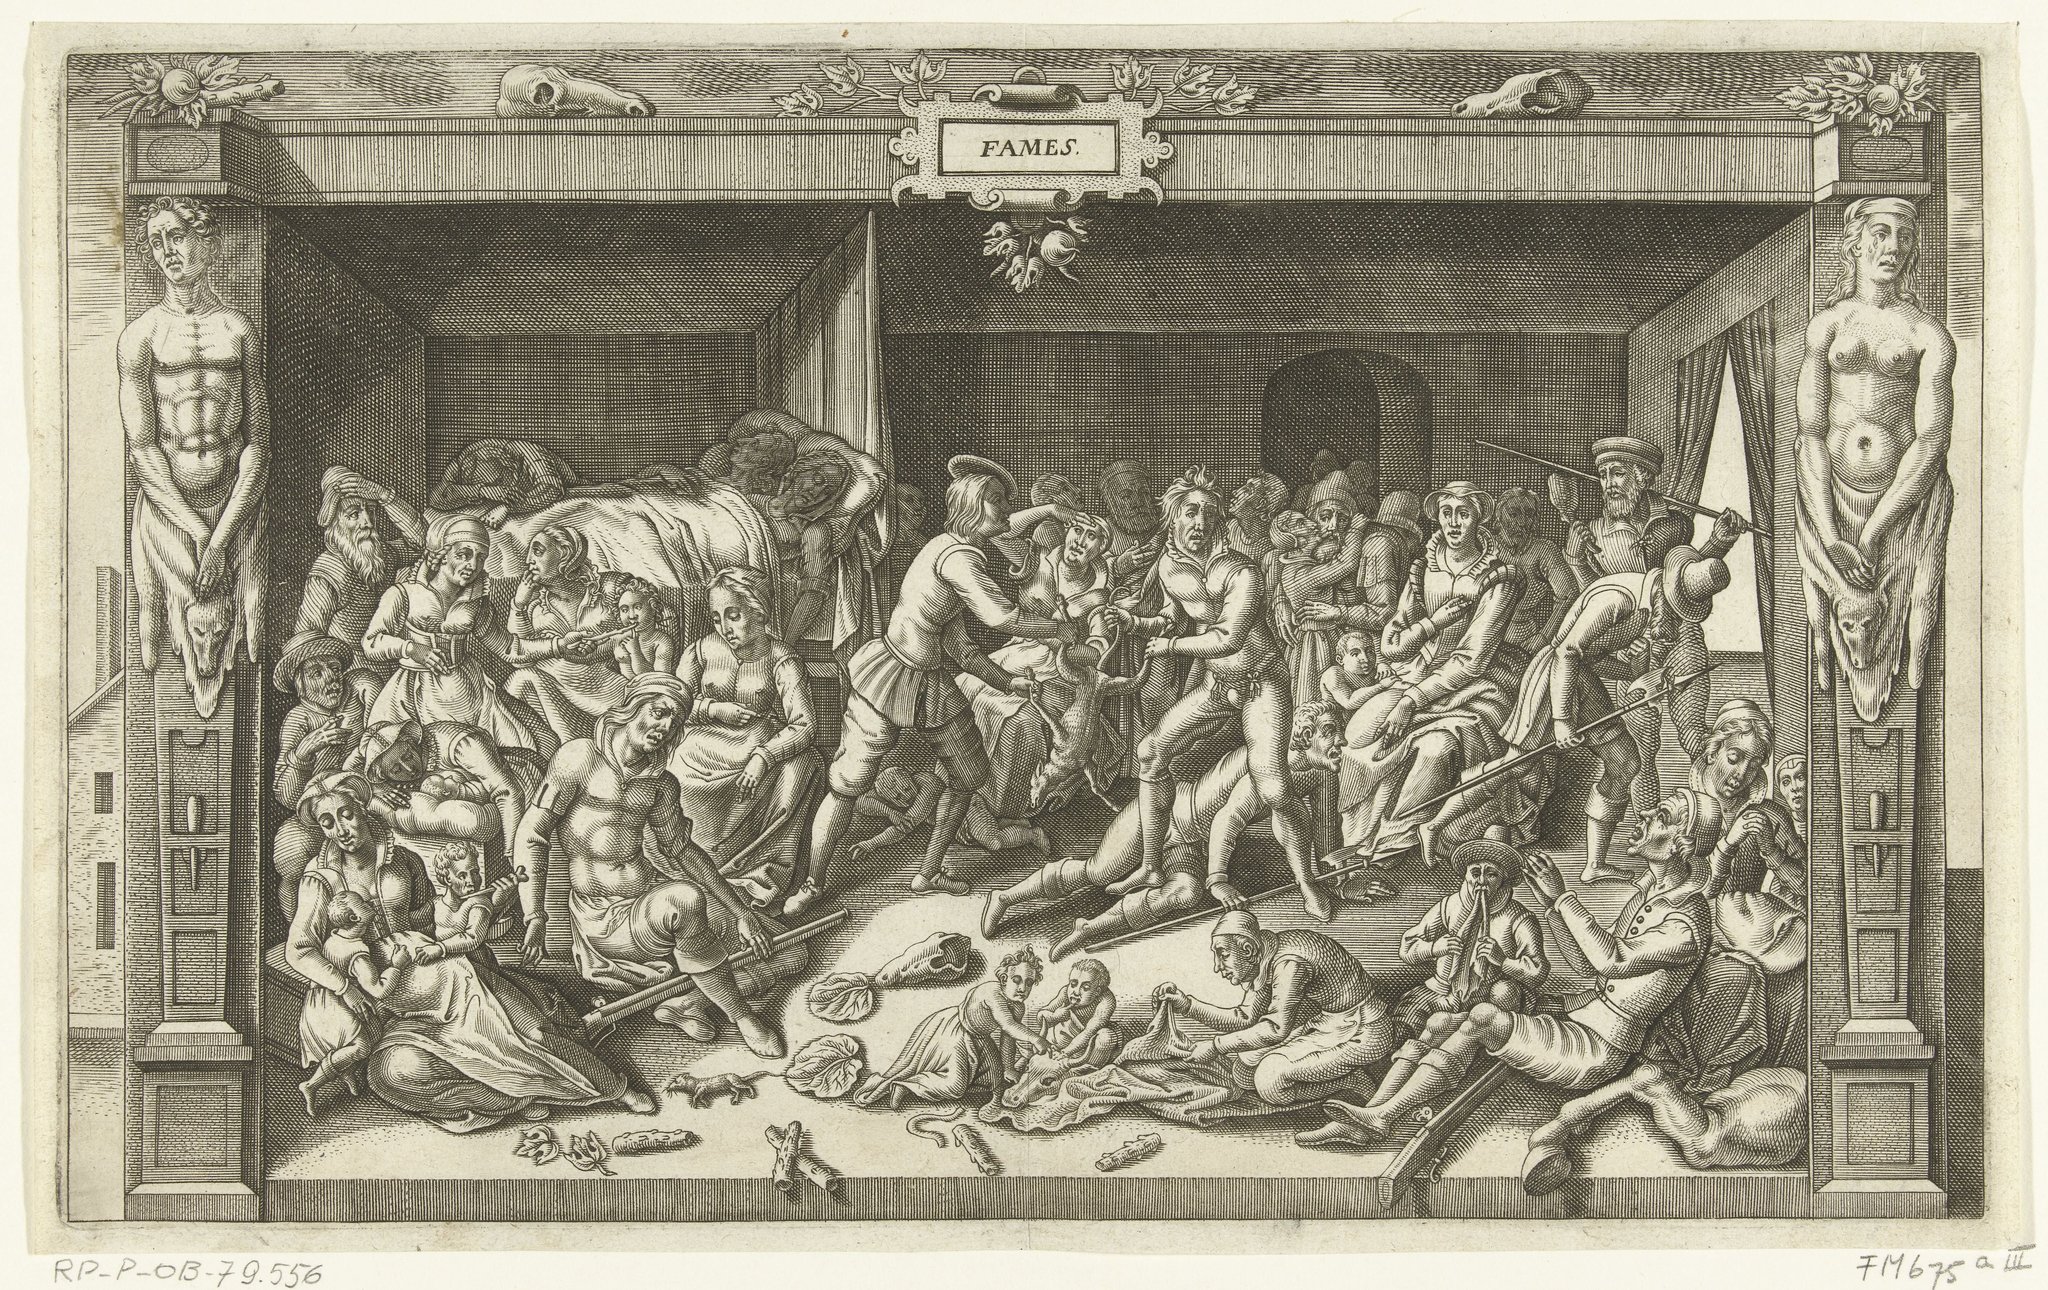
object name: history print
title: Leiden tijdens het beleg en ontzet, 1574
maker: willem de haen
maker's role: draughtsman, print maker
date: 1612-1614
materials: paper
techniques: engraving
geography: northern netherlands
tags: starvation, famine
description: Hongersnood onder de Leidenaren, tijdens het beleg van Leiden, 1574. Interieur met groep Leidse mannen en vrouwen die honger lijden, sterven van uitputting en honger en vechten om het schaarse voedsel. In gebeeldhouwde omlijsting met hermen aan weerszijden.